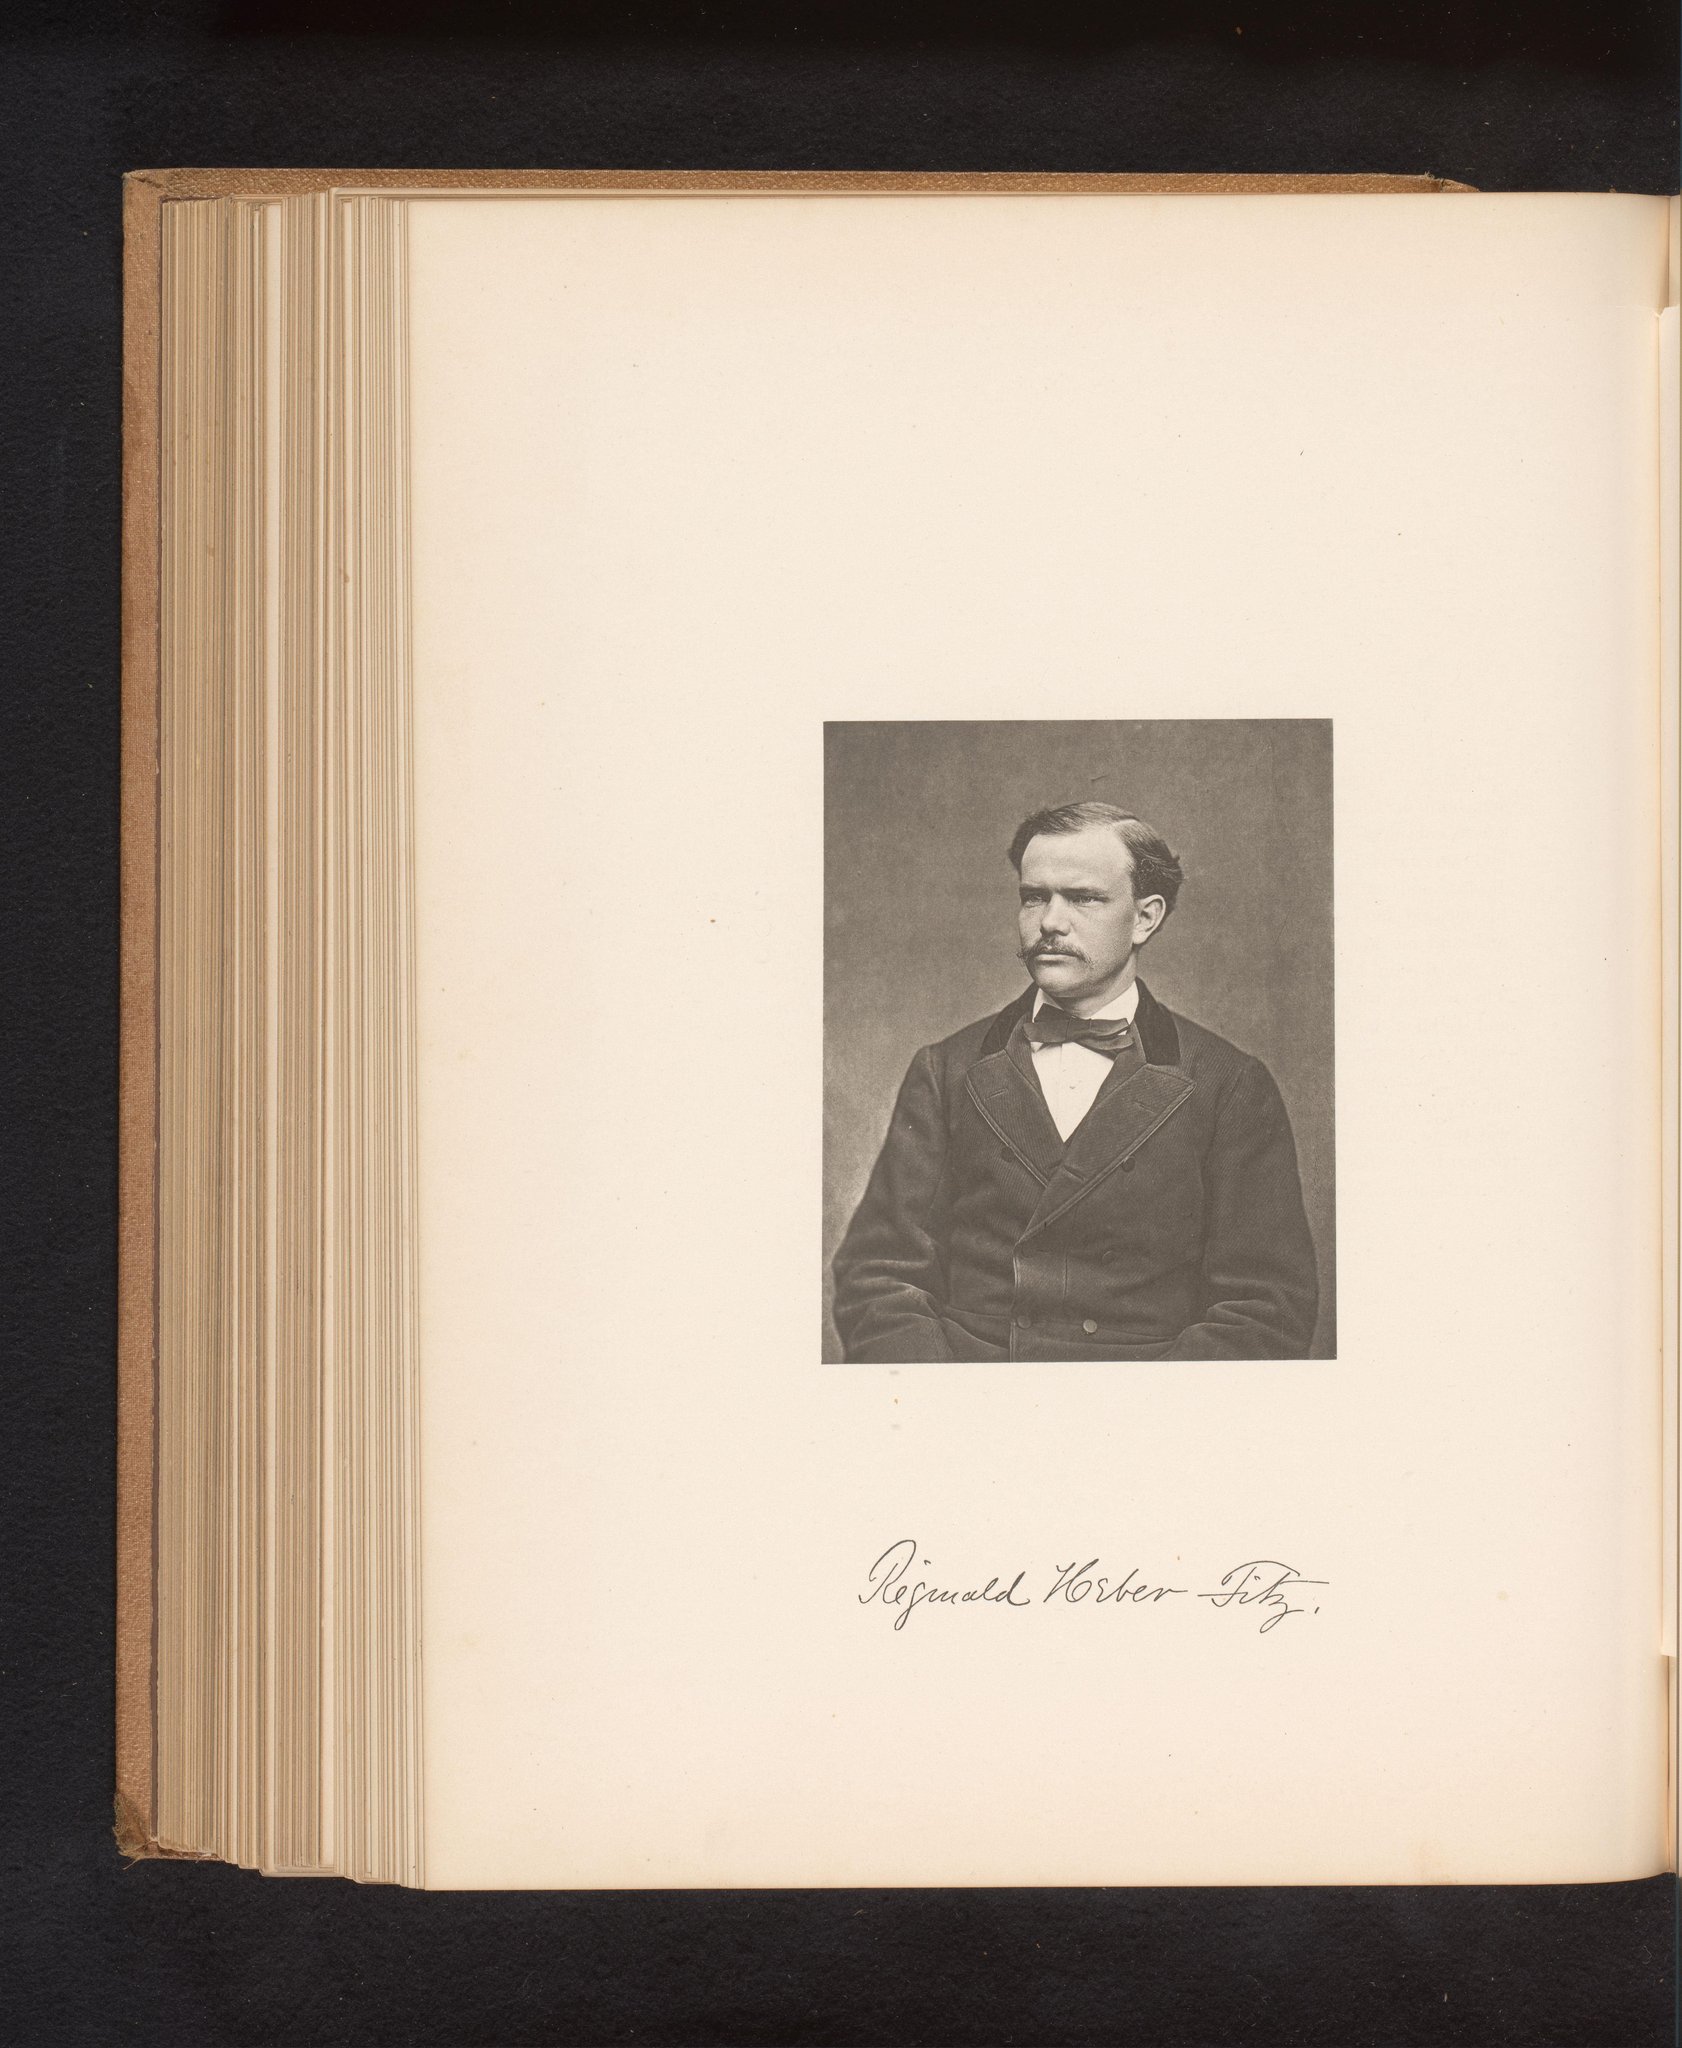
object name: page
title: Reginald Heber Fitz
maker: Anonymous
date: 1870-1875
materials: paper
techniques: photograph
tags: historical persons, physician, doctor, professor